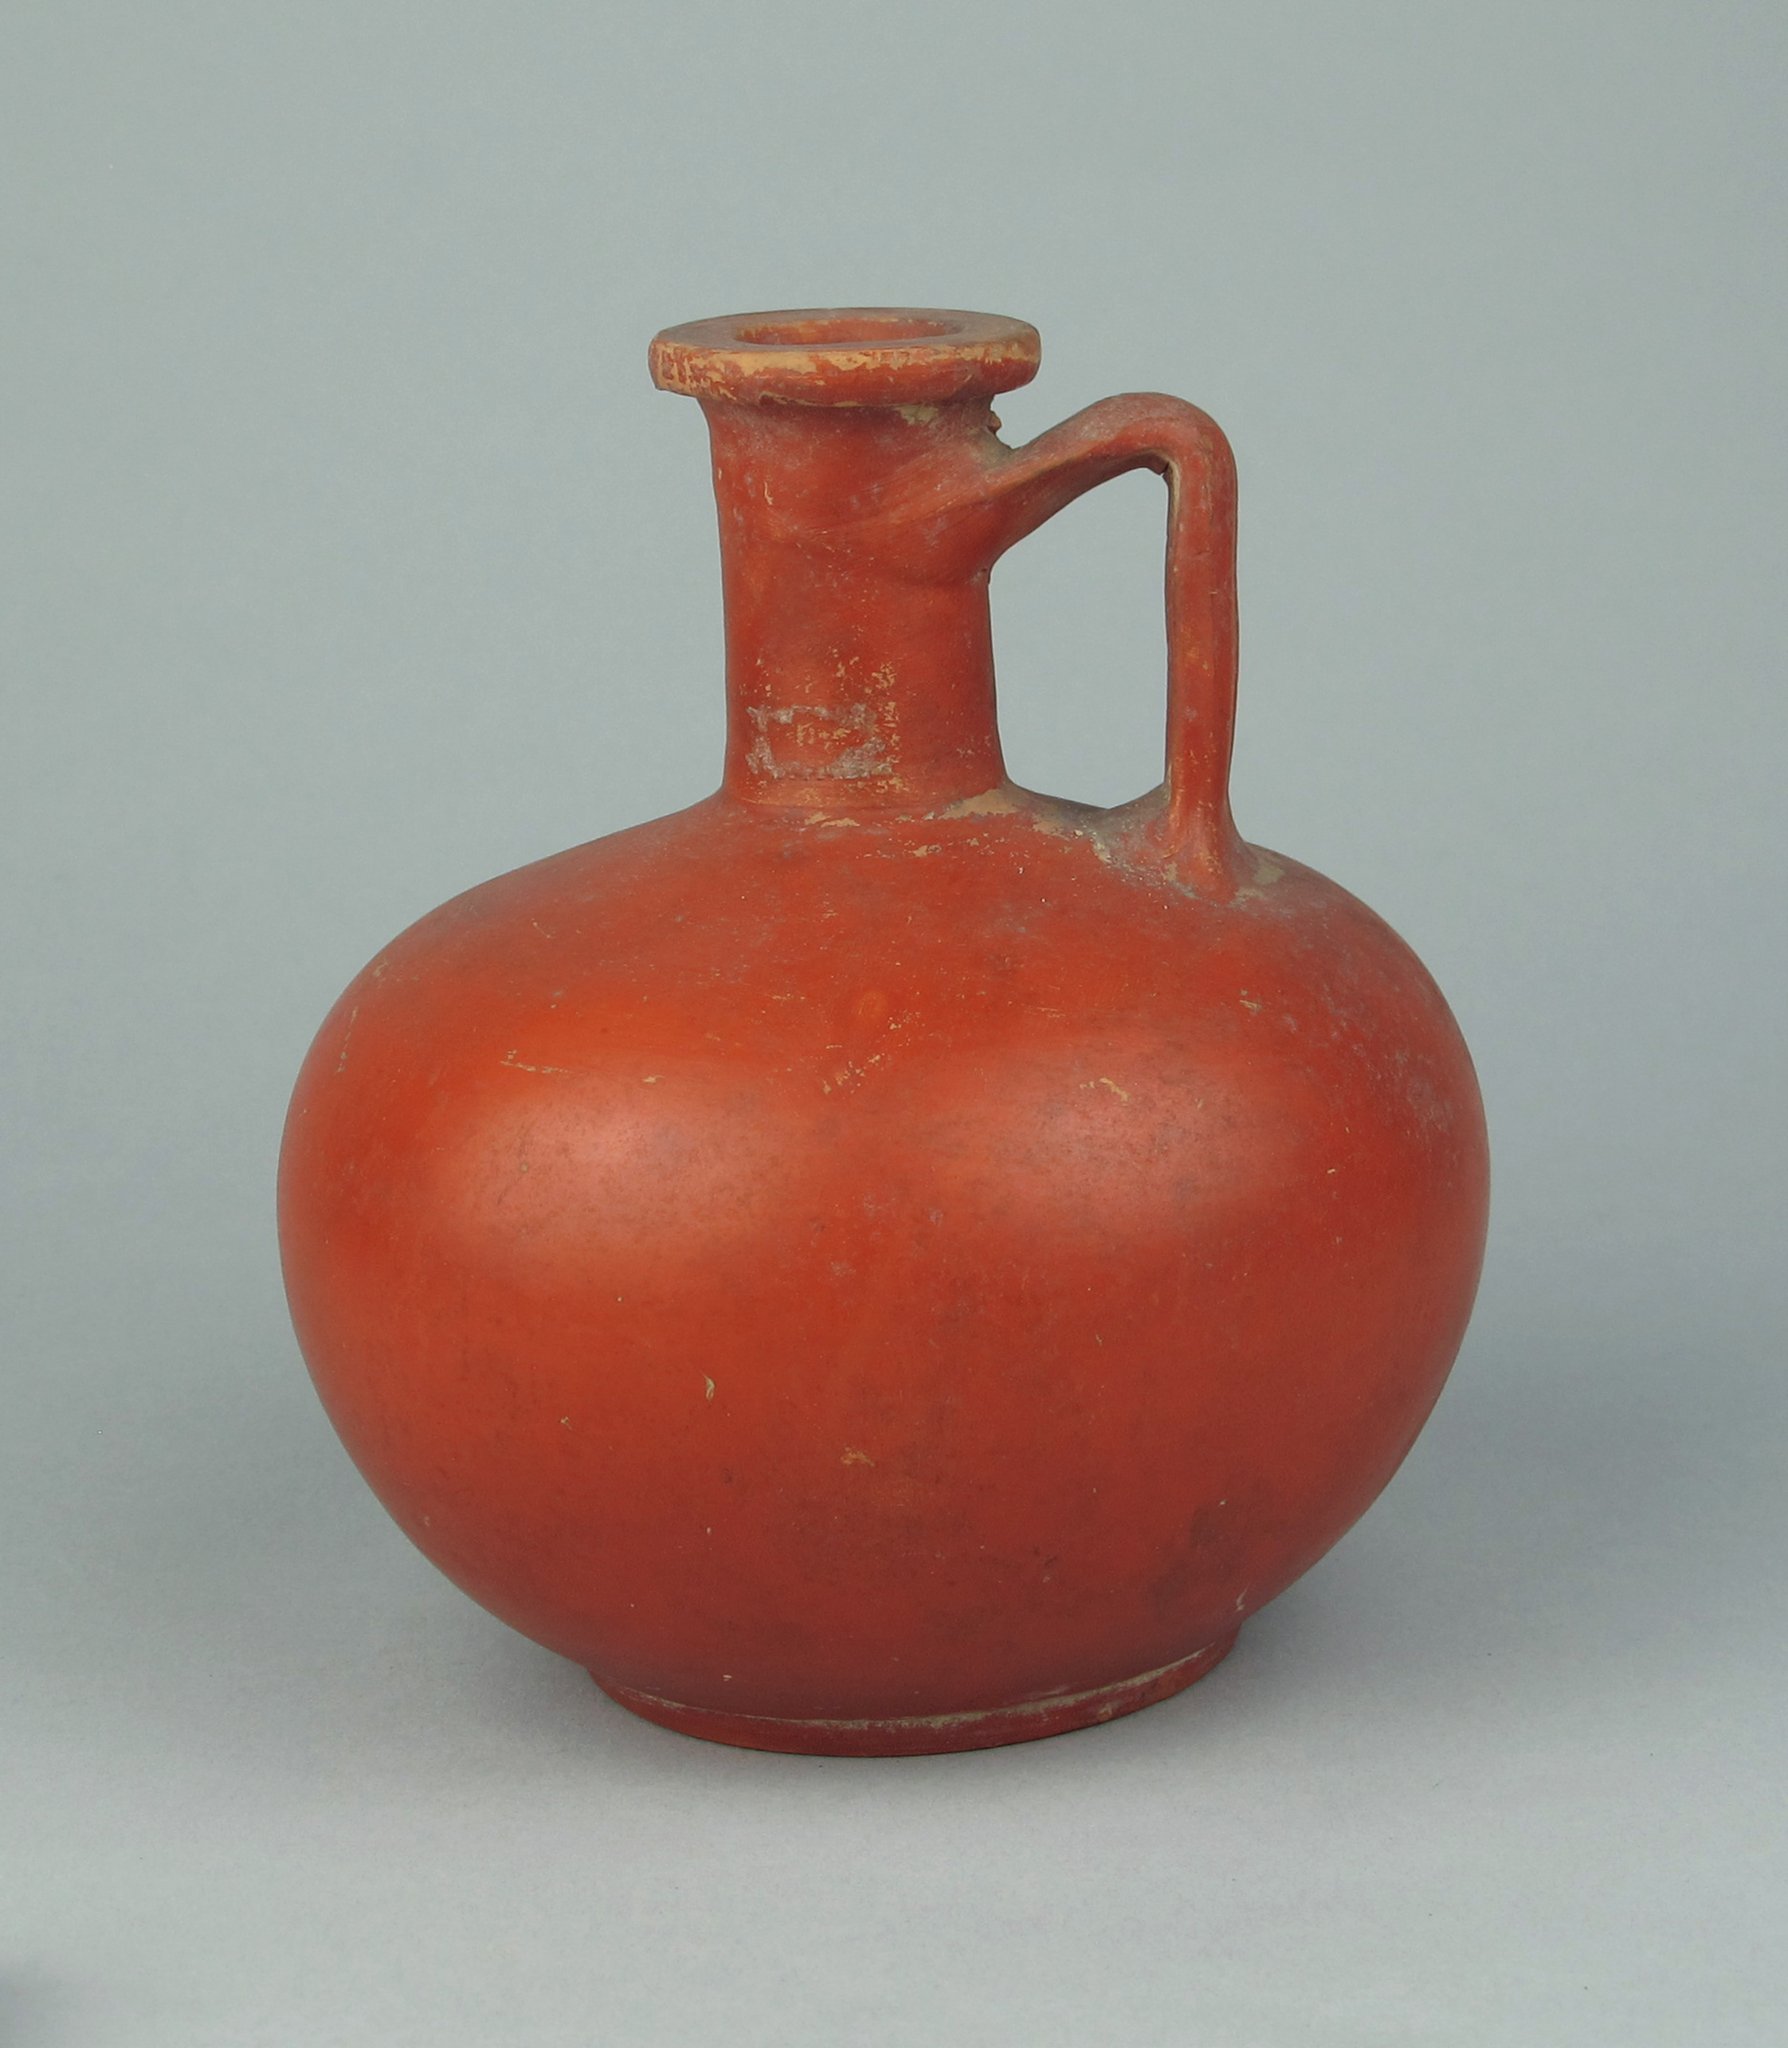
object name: jug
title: Terracotta jug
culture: roman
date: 7000 BCE-330 CE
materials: terracotta